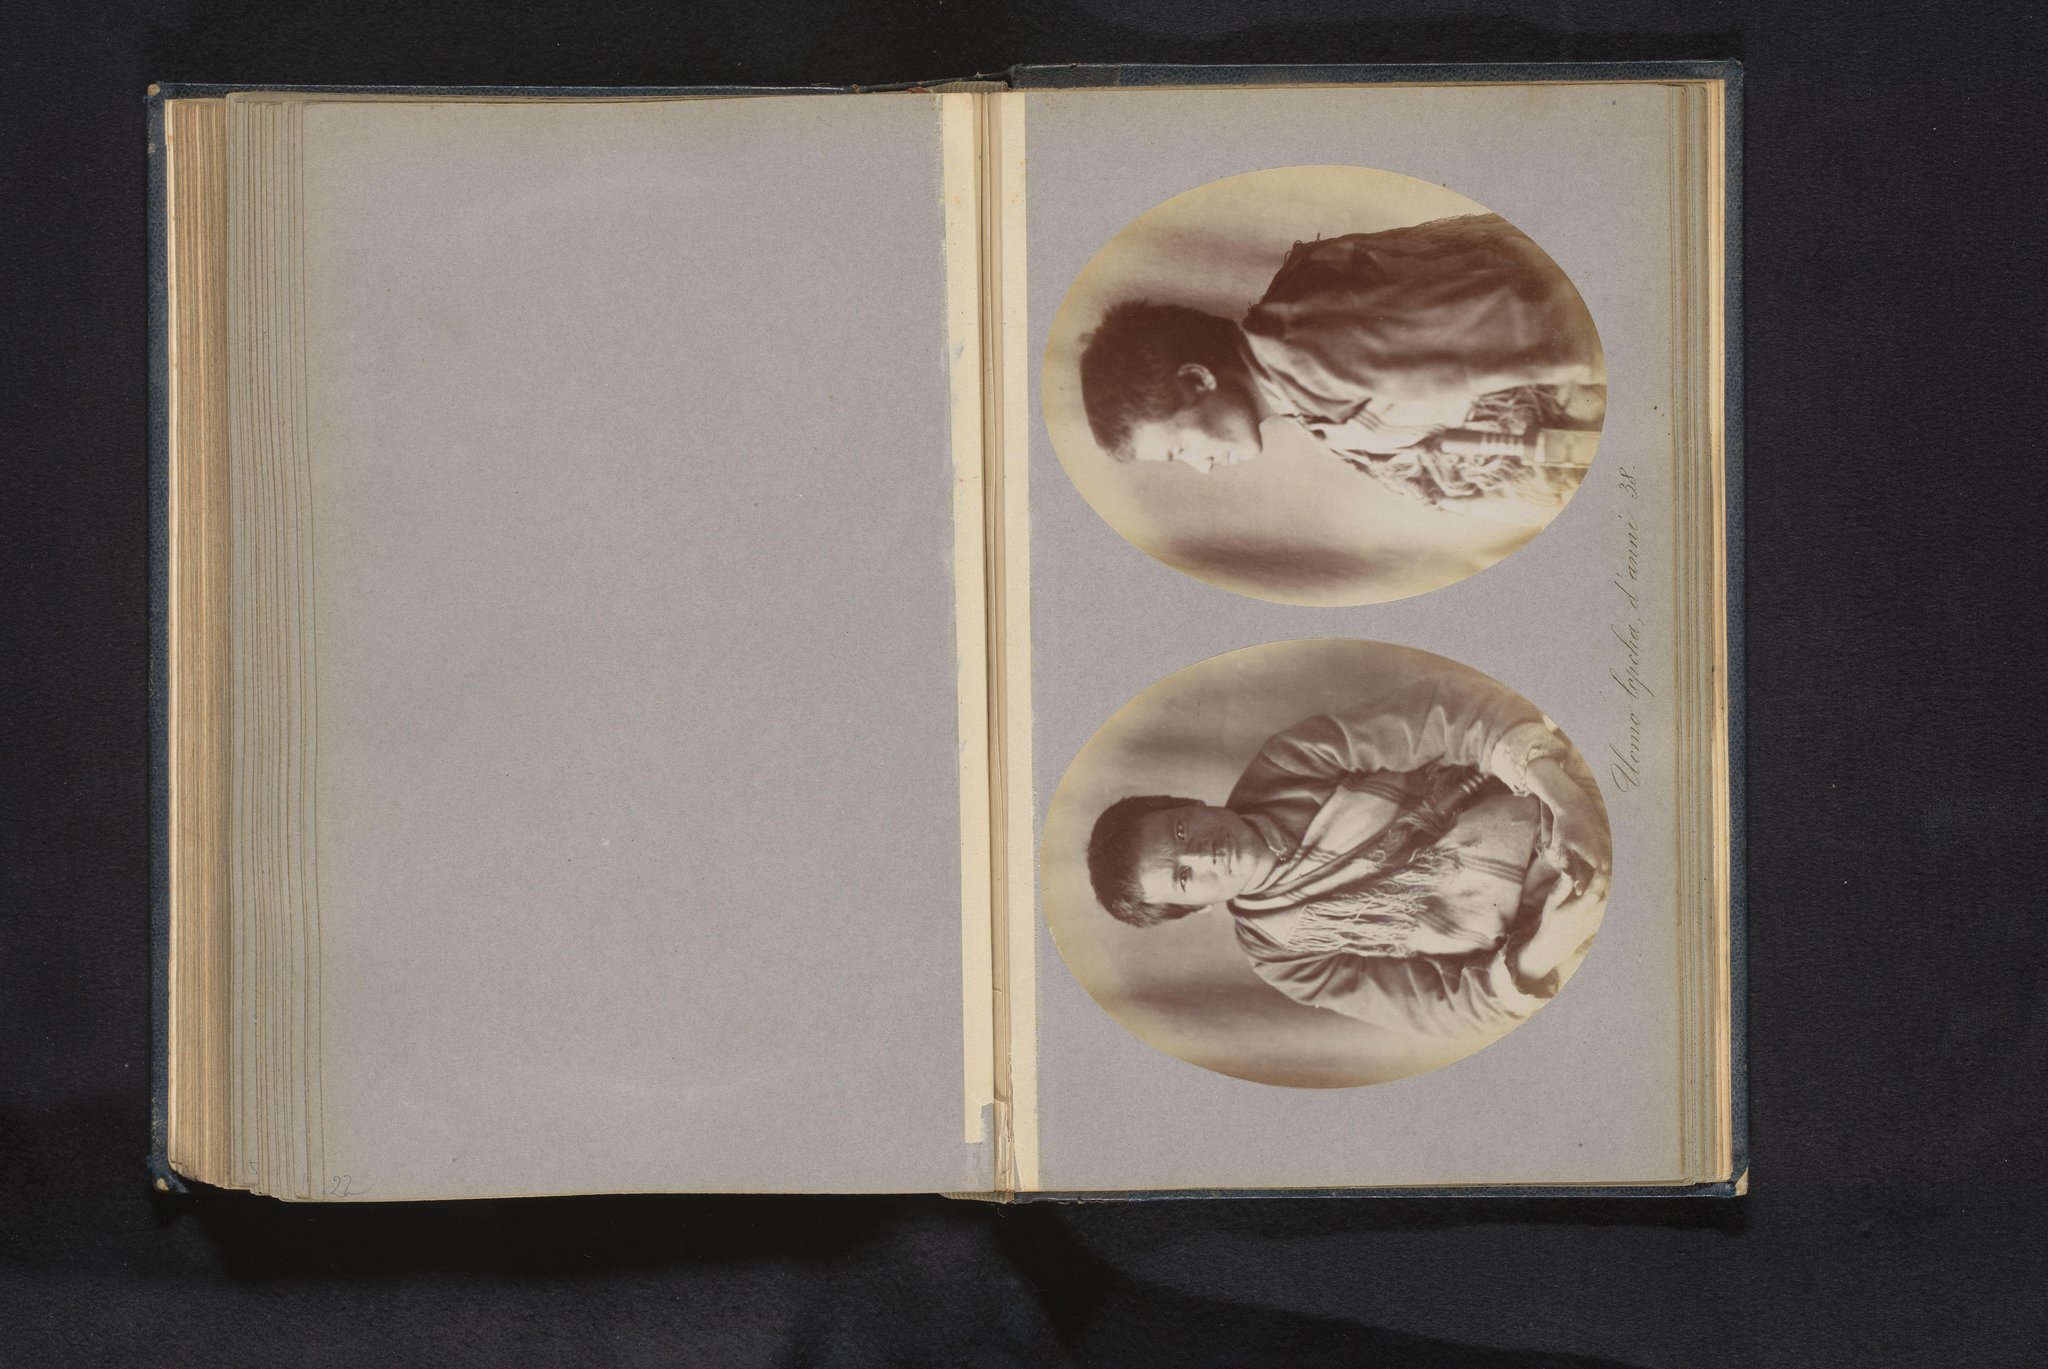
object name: photograph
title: Uomo lepcha, d'anni 38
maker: paolo mantegazza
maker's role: antropoloog, professor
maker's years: 1831-1910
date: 1881-1886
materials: photographic support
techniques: albumen print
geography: india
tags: adult man (+ front view), adult man (+ sideview, profile)